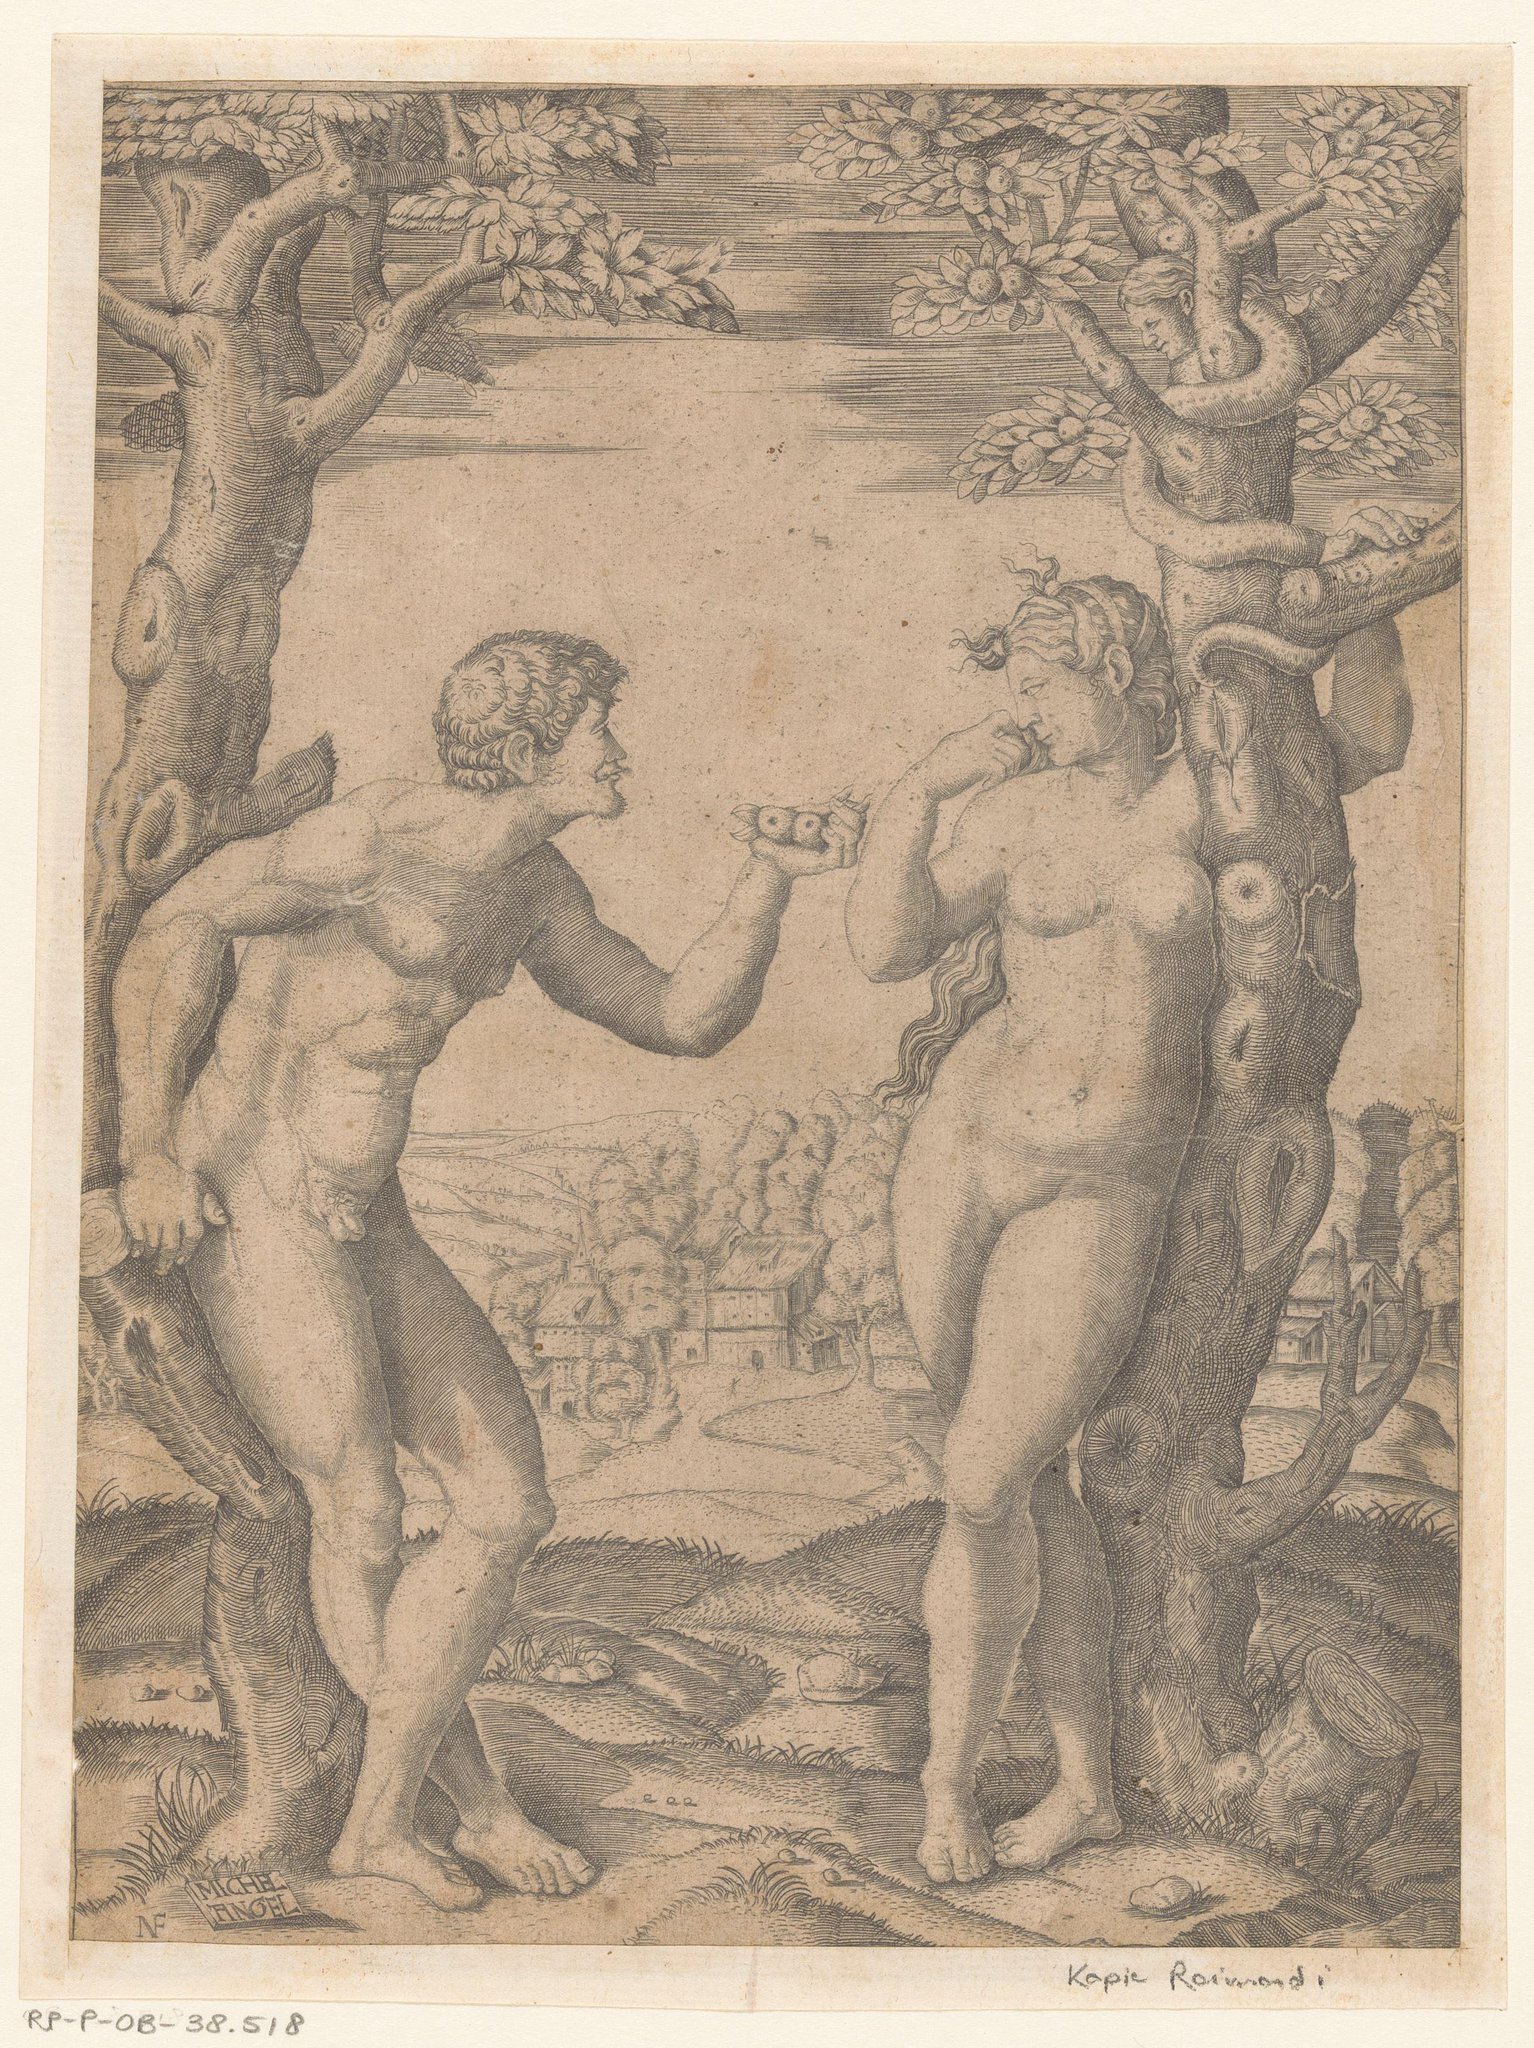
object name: print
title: Zondeval van Adam en Eva bij boom van kennis van goed en kwaad met slang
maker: monogrammist nf (graveur)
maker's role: print maker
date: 1500-1599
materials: paper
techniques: engraving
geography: italy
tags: temptation and fall (scenes with both adam and eve)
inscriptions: collector's mark: Lugt 2228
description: Eva staat rechts bij de boom met de slang. Links staat Adam met twee vruchten in zijn hand.